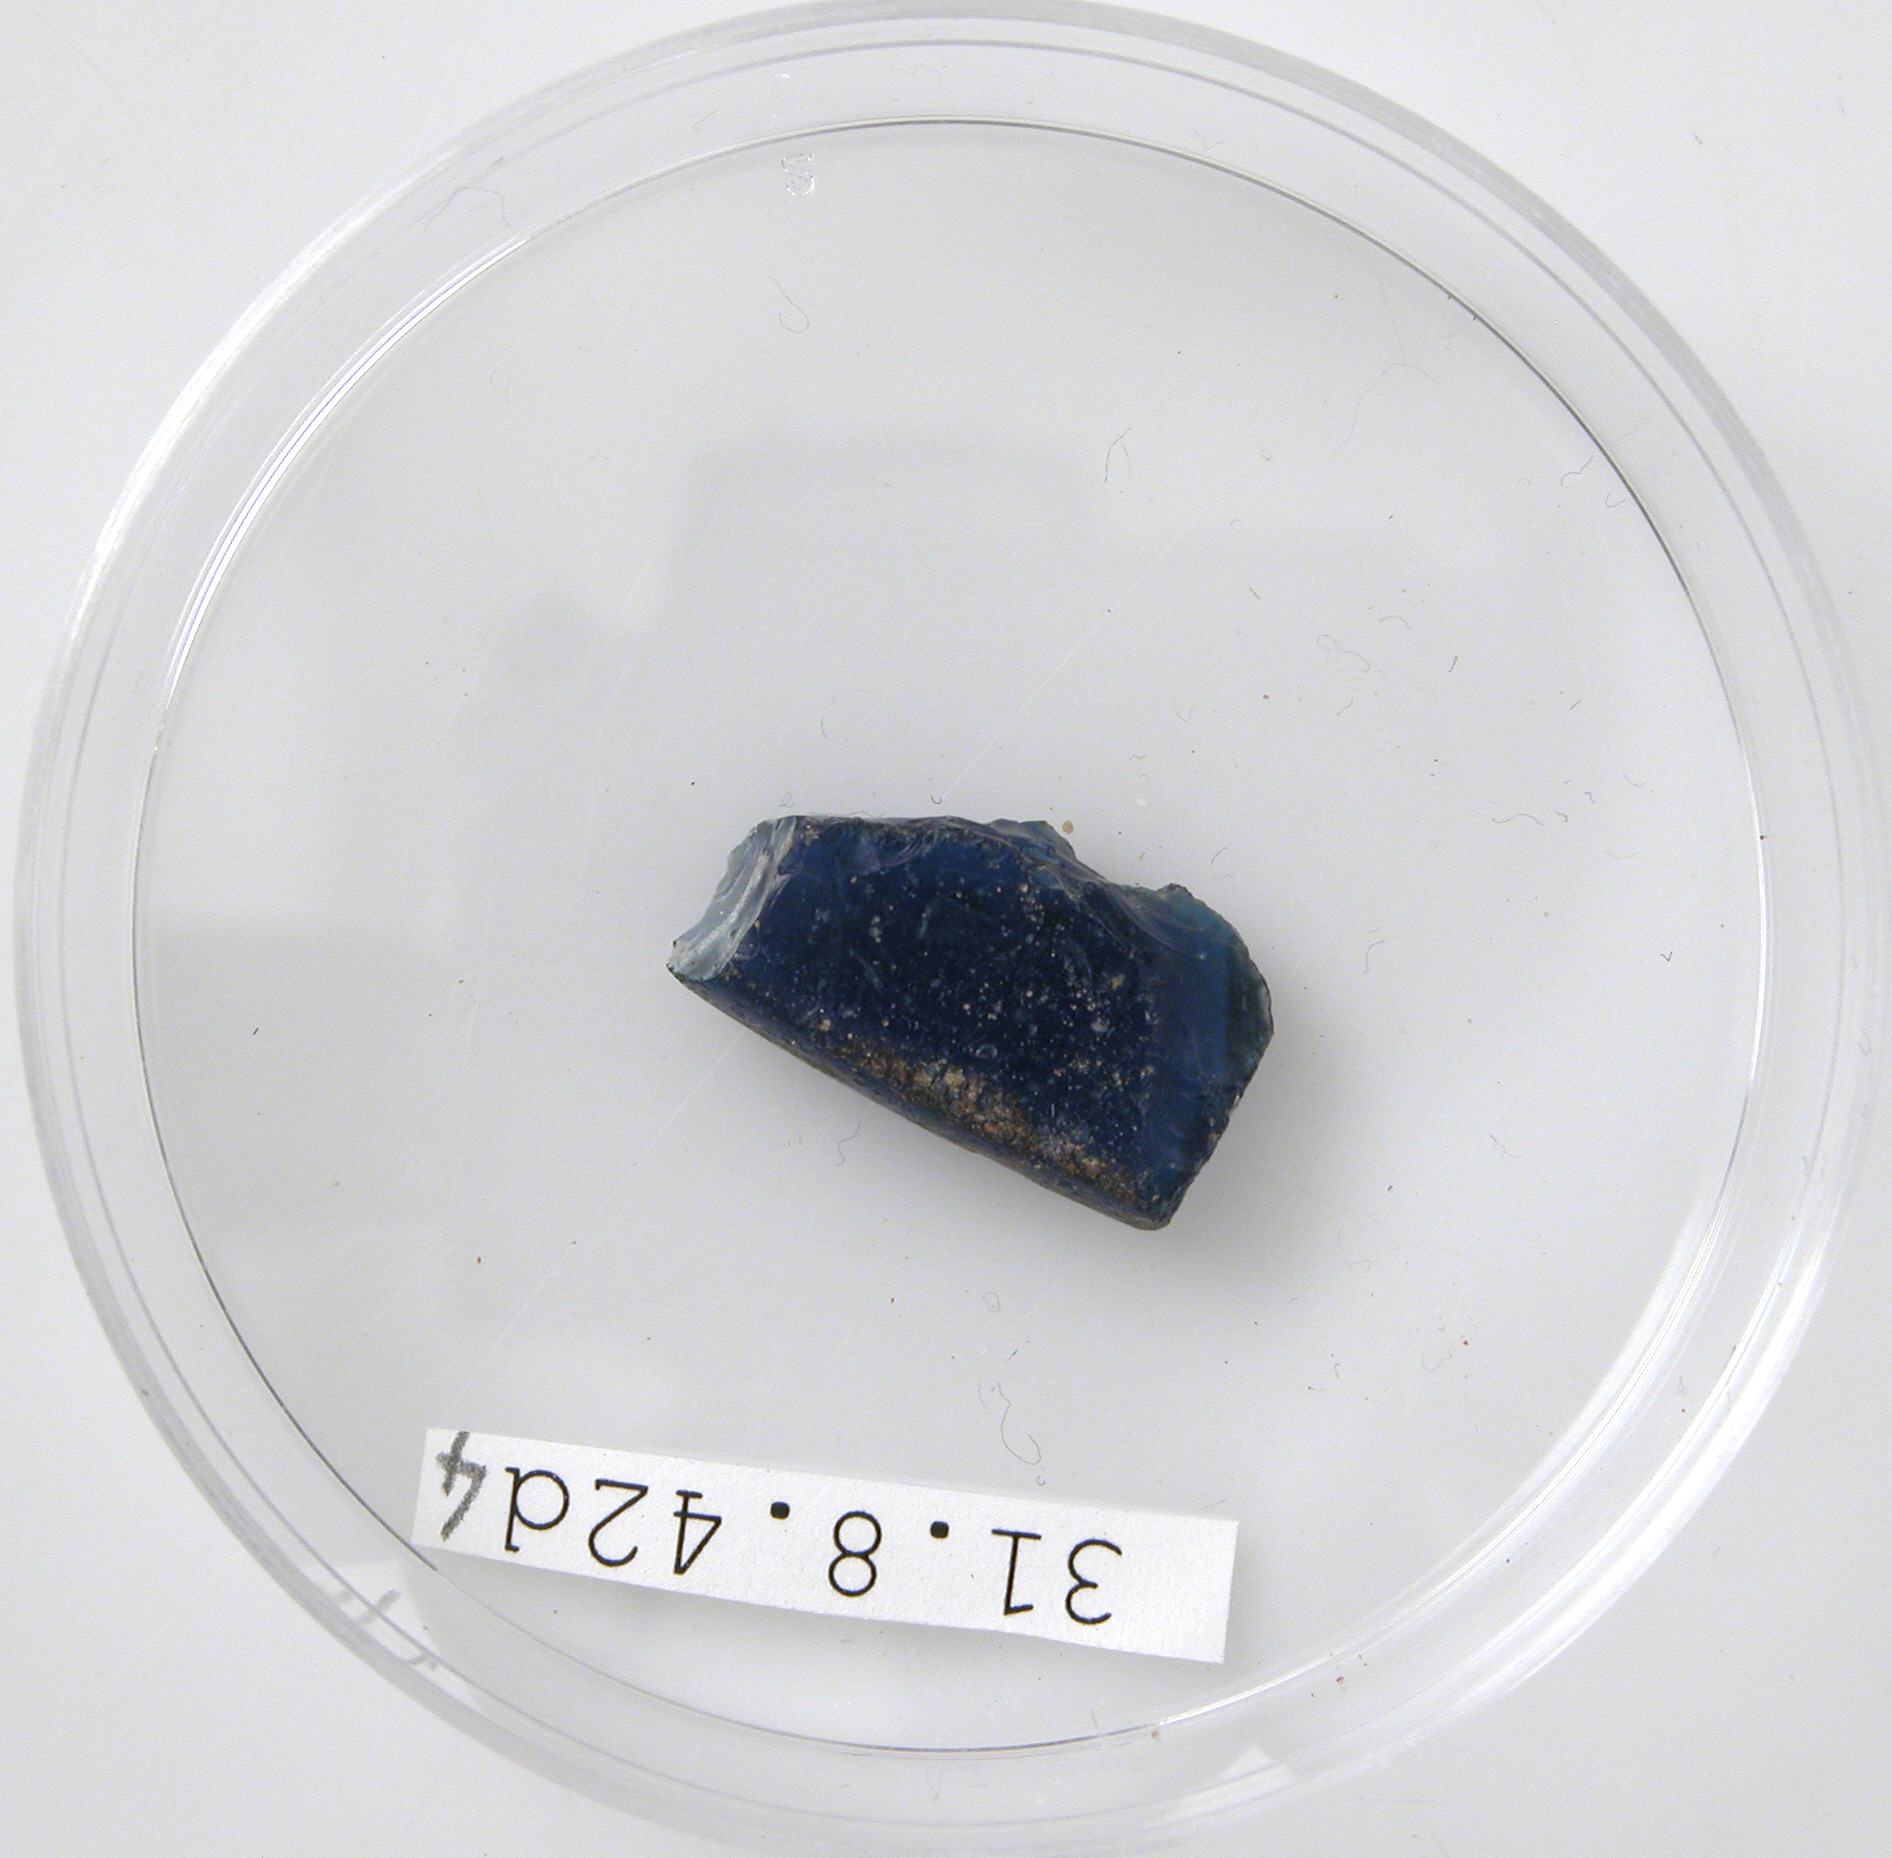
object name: fragment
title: Glass Fragment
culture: coptic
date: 301-400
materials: glass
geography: egypt